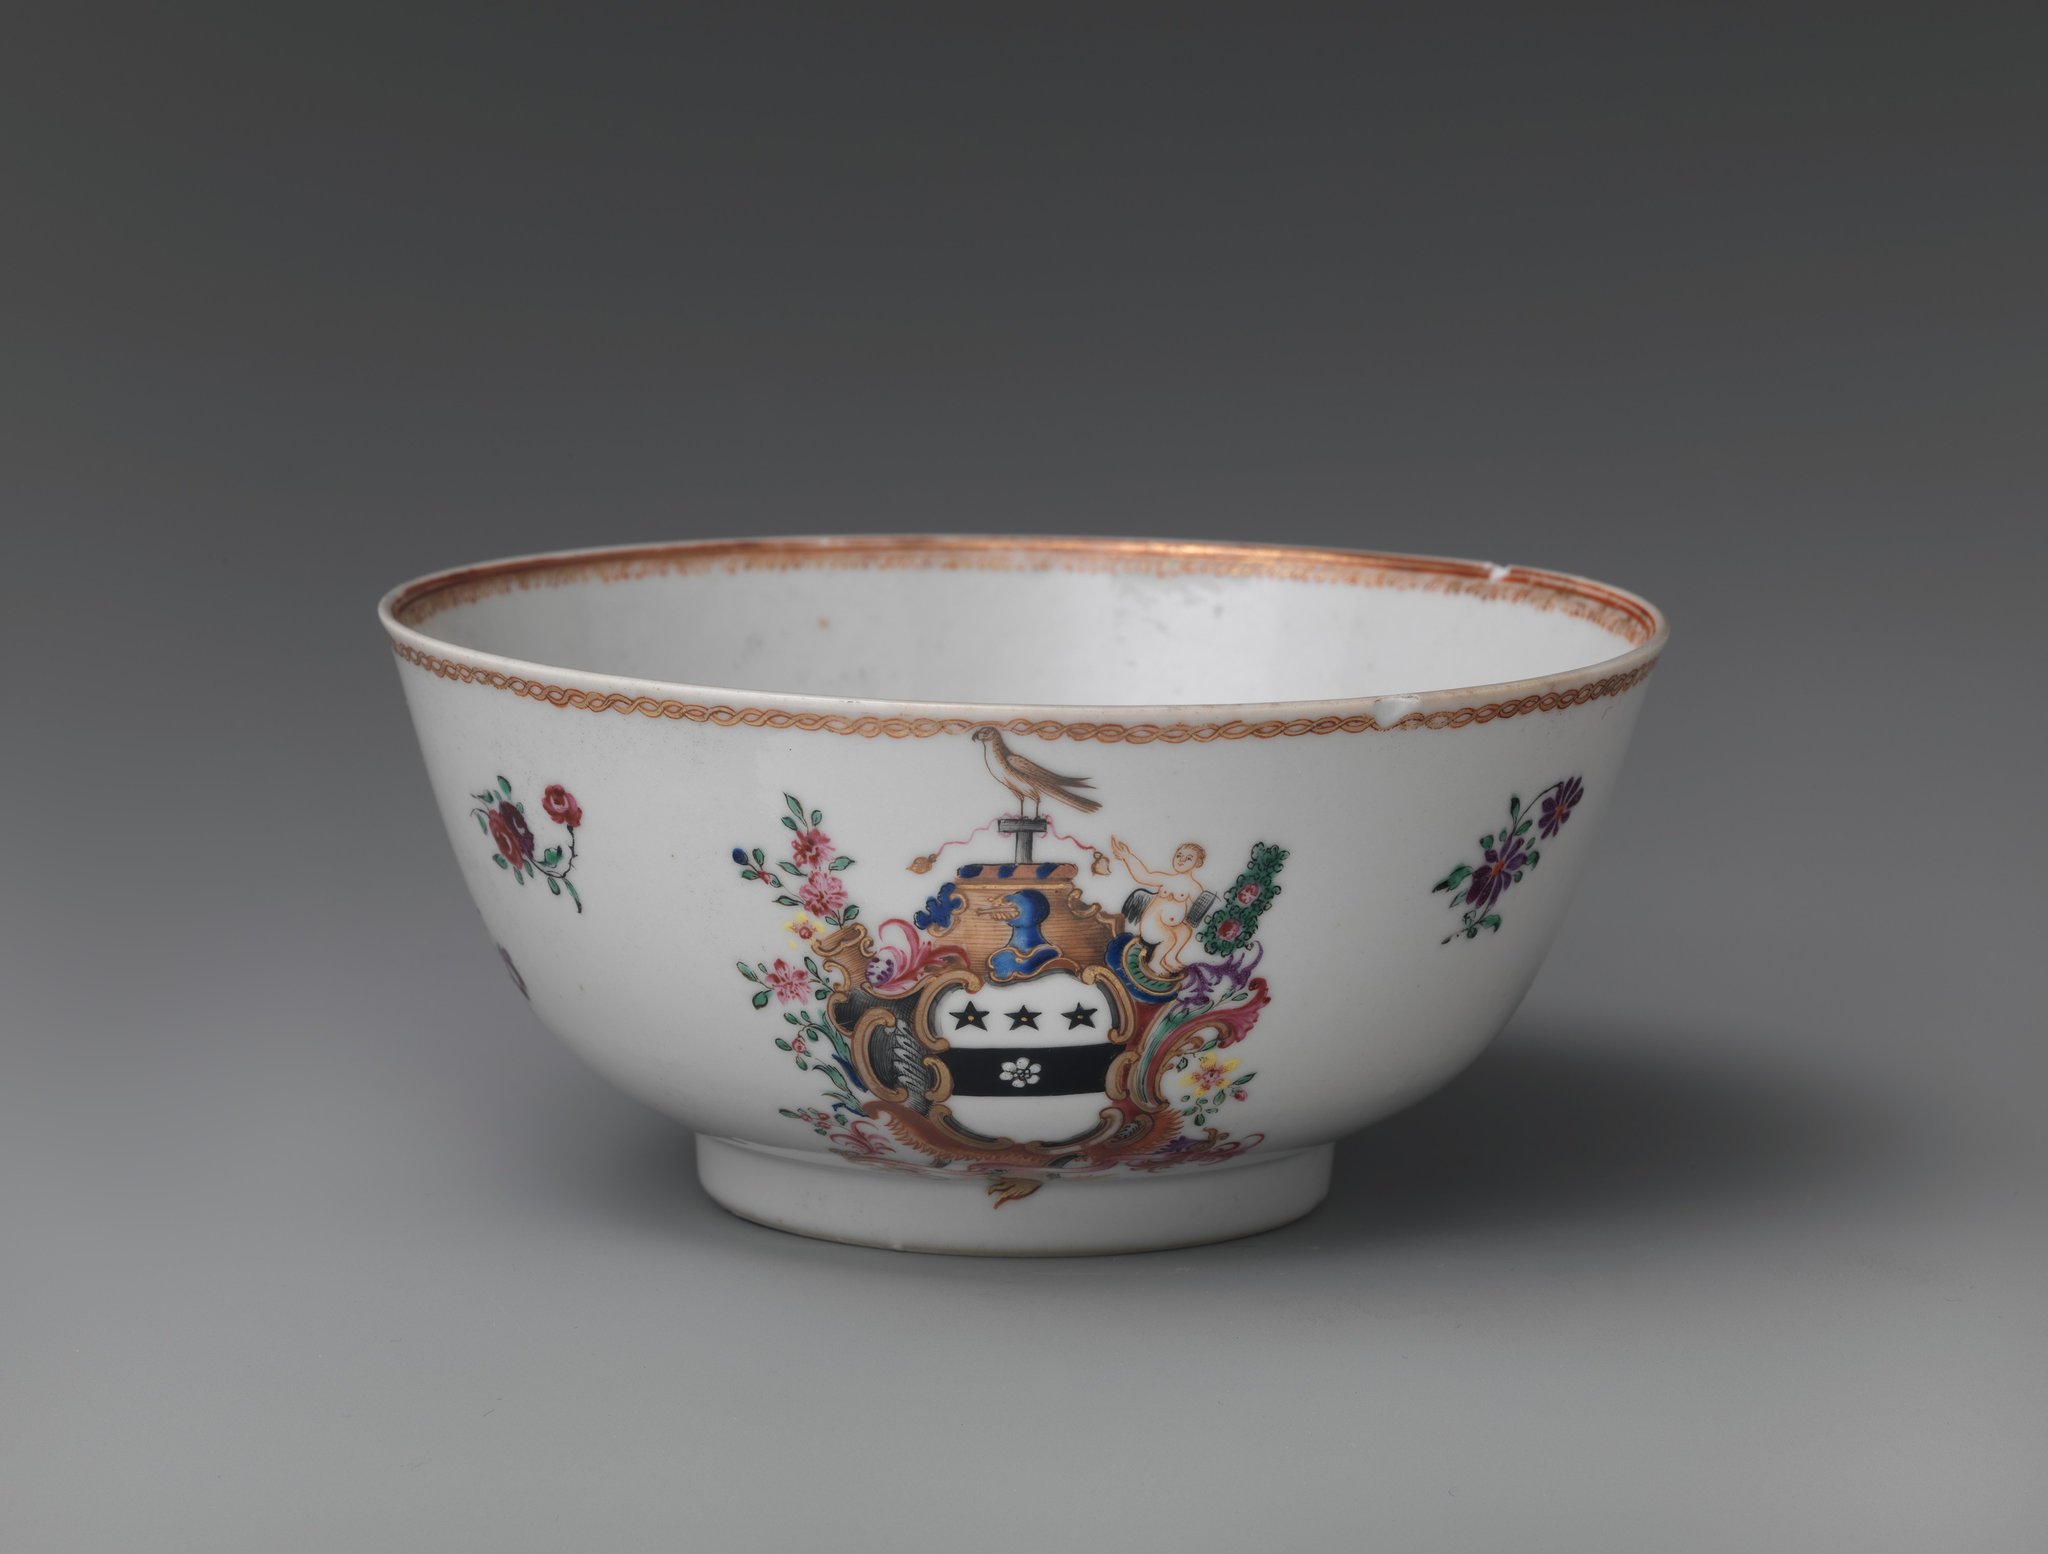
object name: bowl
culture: chinese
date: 1785-1790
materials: porcelain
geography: china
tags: birds,coat of arms